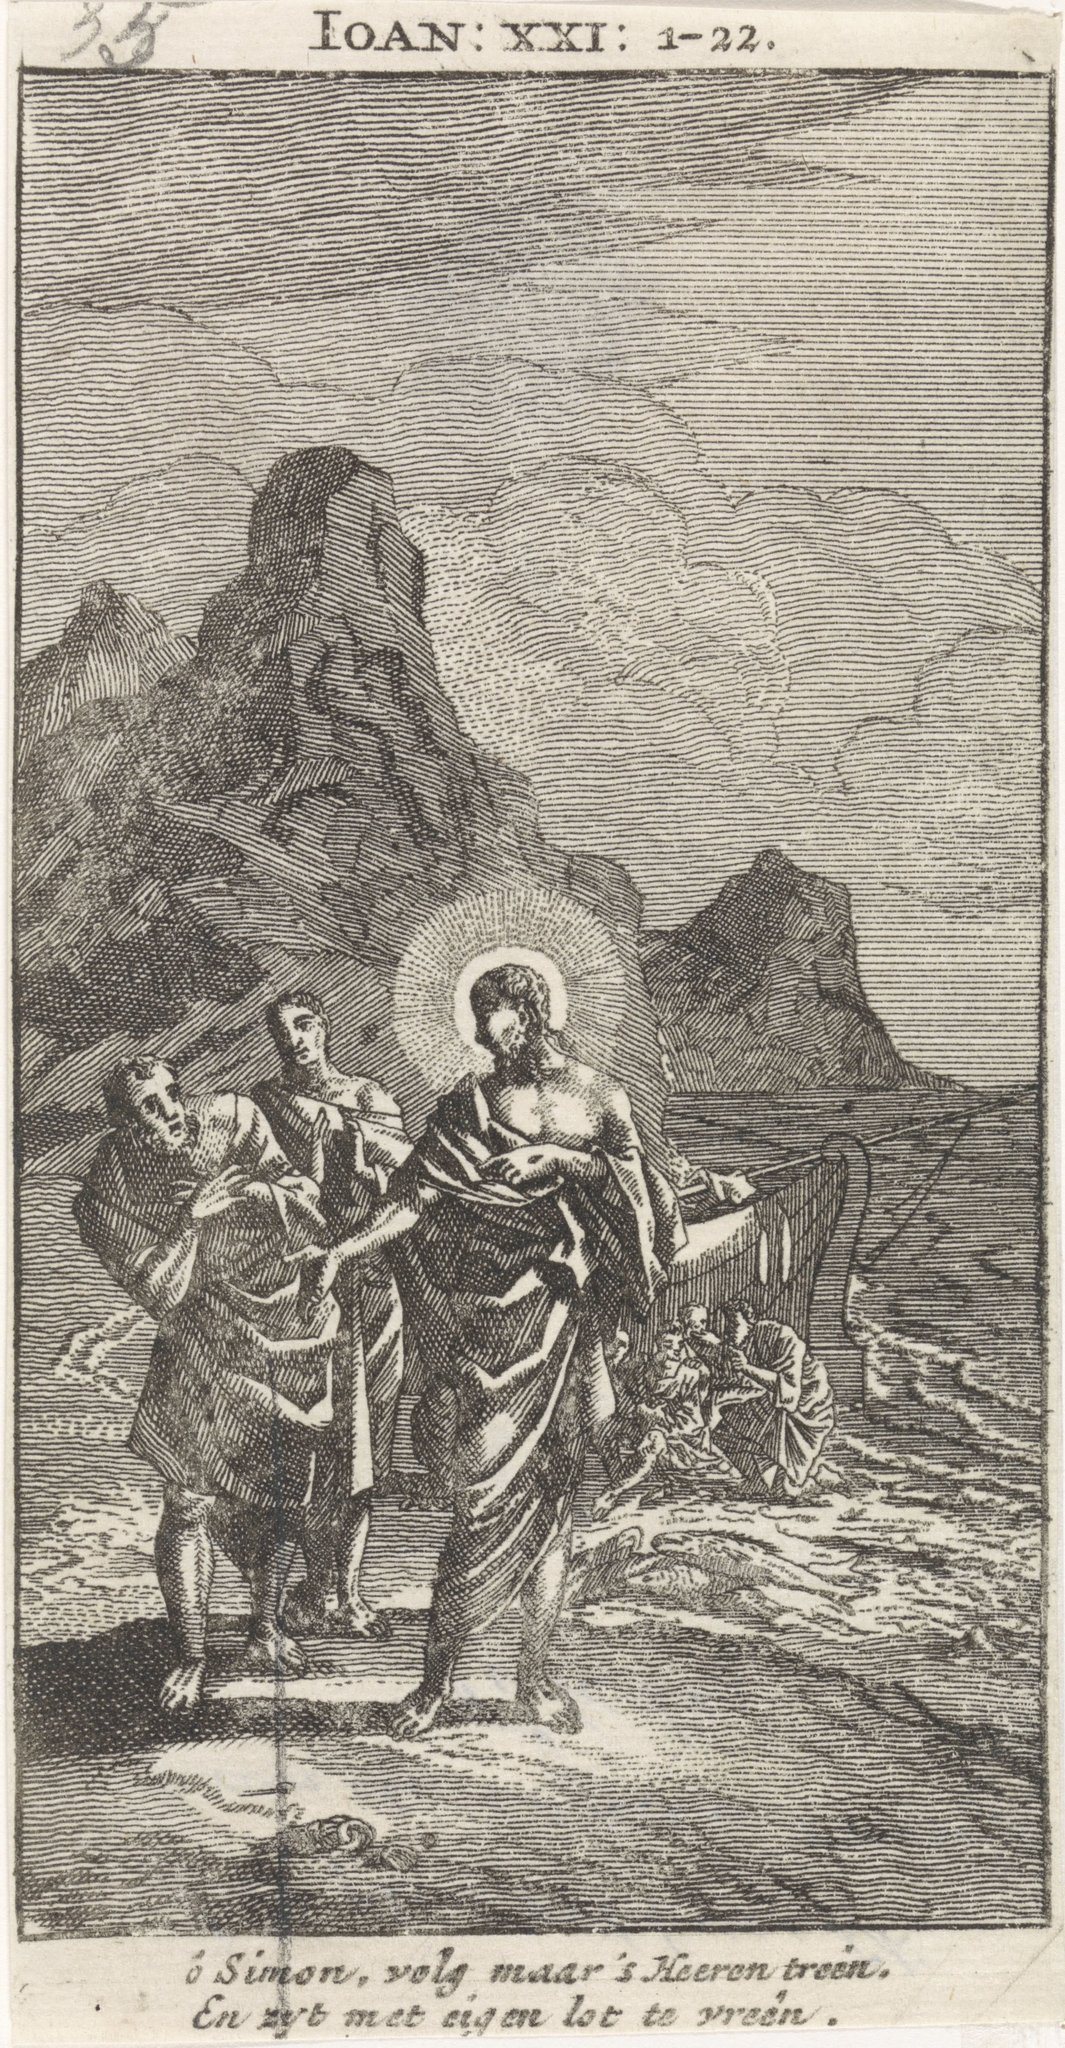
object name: print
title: Christus verschijnt bij het Meer van Galilea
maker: Anonymous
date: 1712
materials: paper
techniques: etching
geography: amsterdam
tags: appearance of christ at the lake of gennesaret (sea of galilee, sea of tiberias): miraculous draught of fishes (after the resurrection)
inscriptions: collector's mark: Lugt 2228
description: Kopie van illustratie voor: Luyken, Jan. Bybel printen. Amsterdam: Pieter Arentsz. II (wed.) en Cornelis van der Sys, 1712, p. 34.